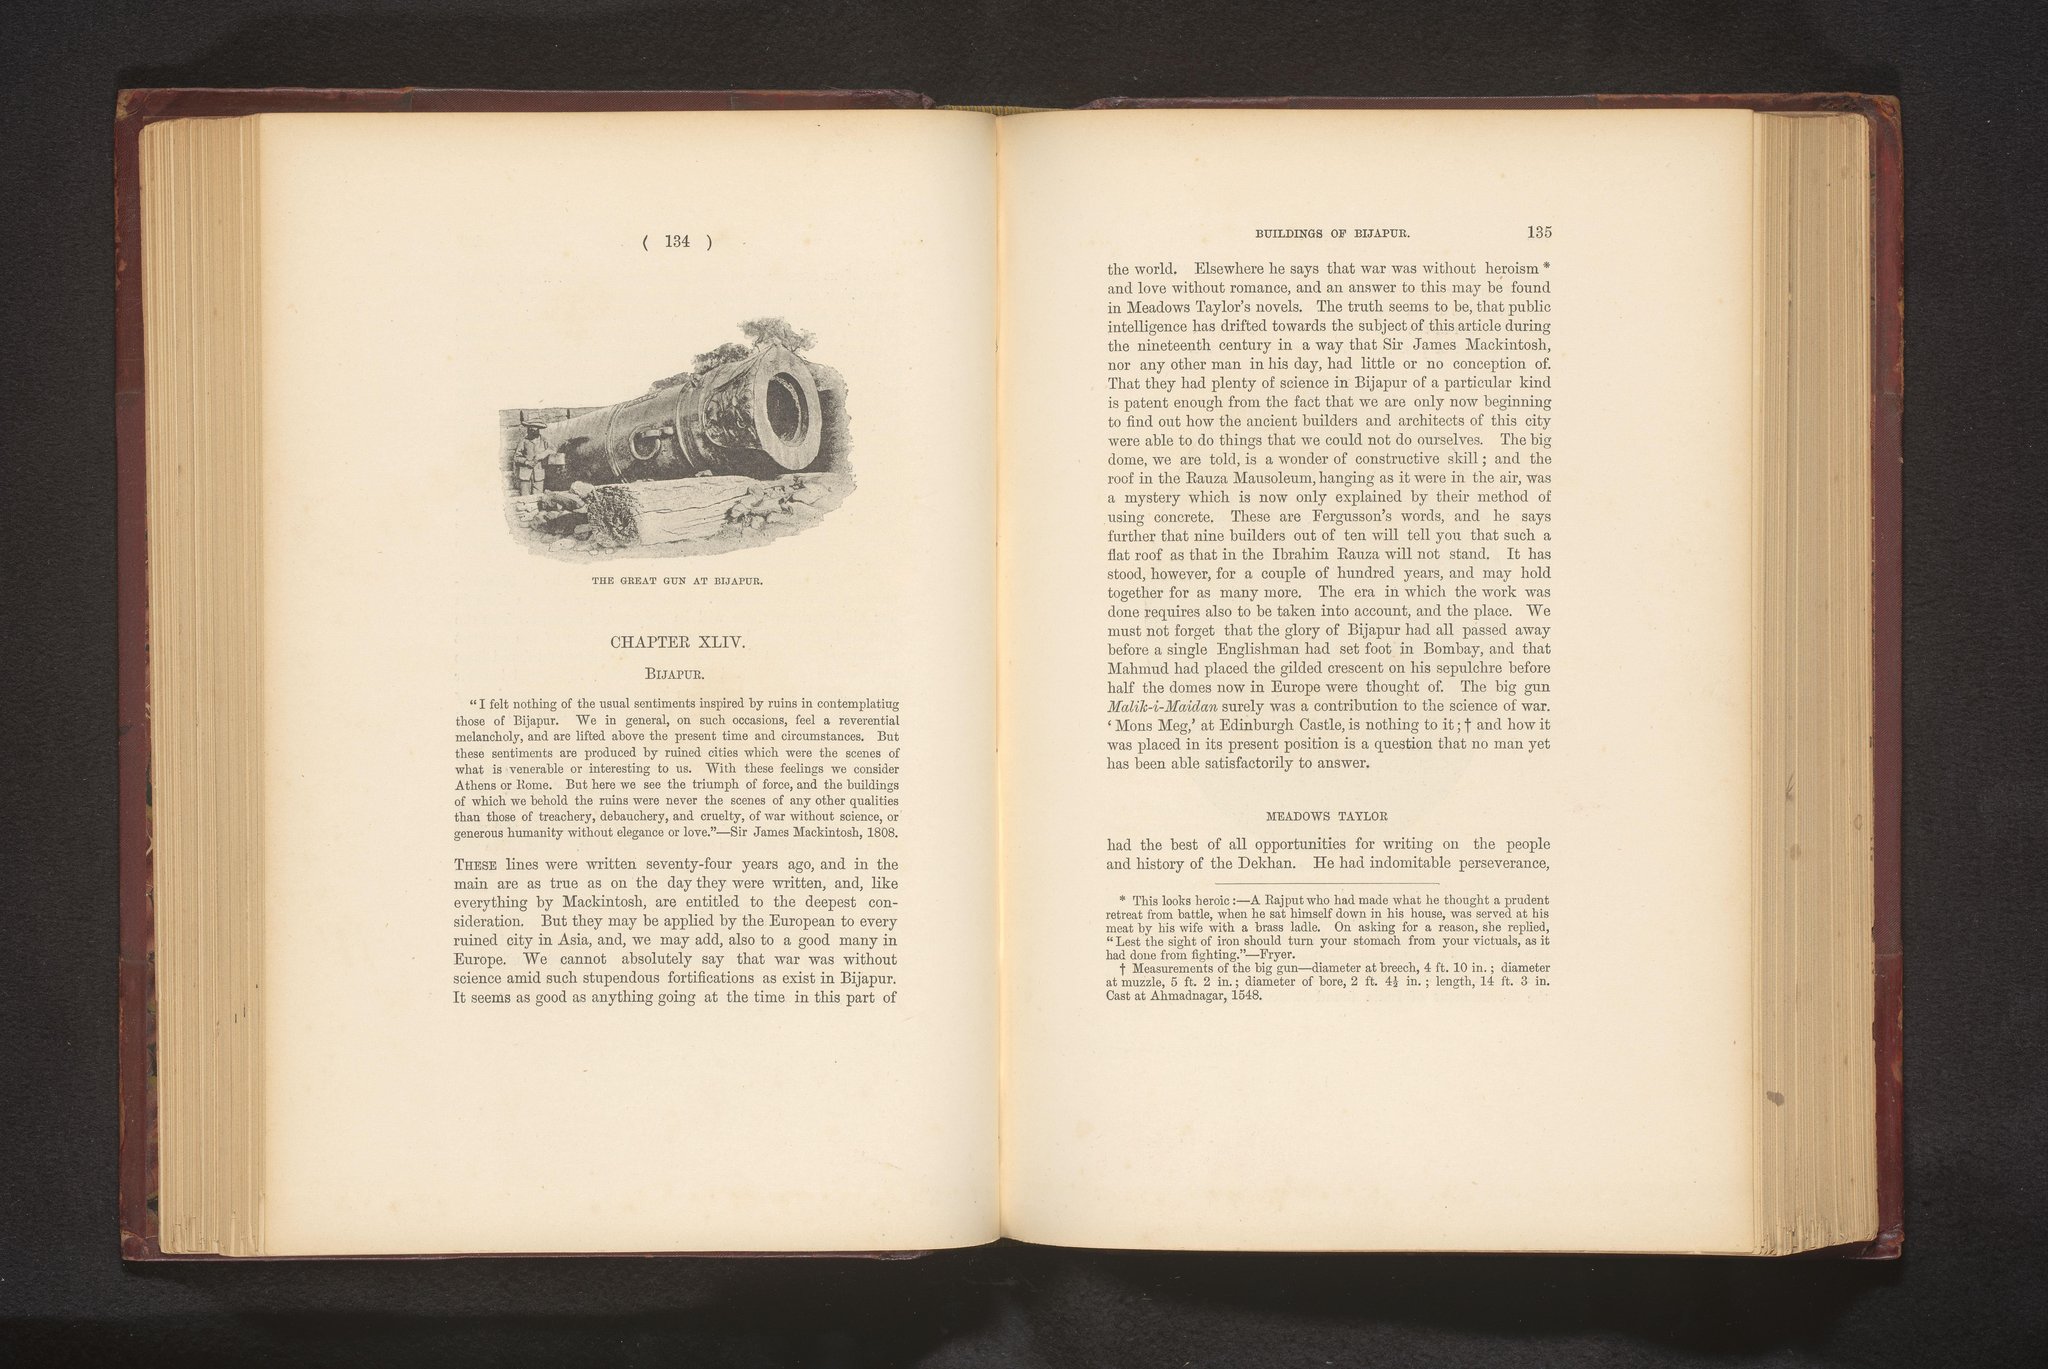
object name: photomechanical print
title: The great gun of Bijapur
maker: Anonymous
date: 1883-1893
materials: paper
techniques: autotype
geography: bijapur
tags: firearms: cannon